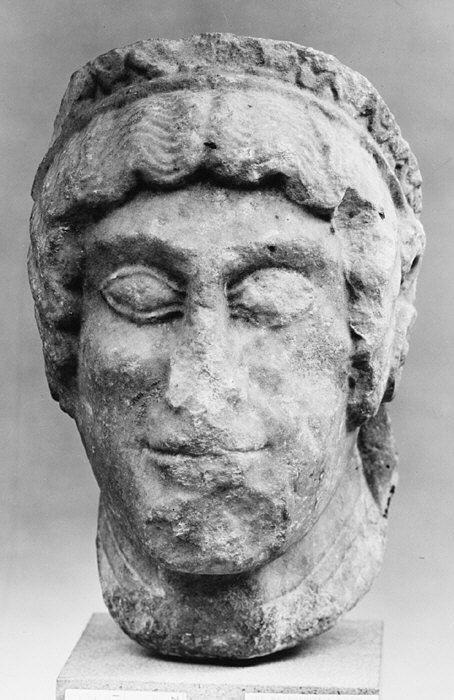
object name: head of a woman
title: Head of a marble kore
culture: greek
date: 600-501 BCE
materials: marble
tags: heads,women